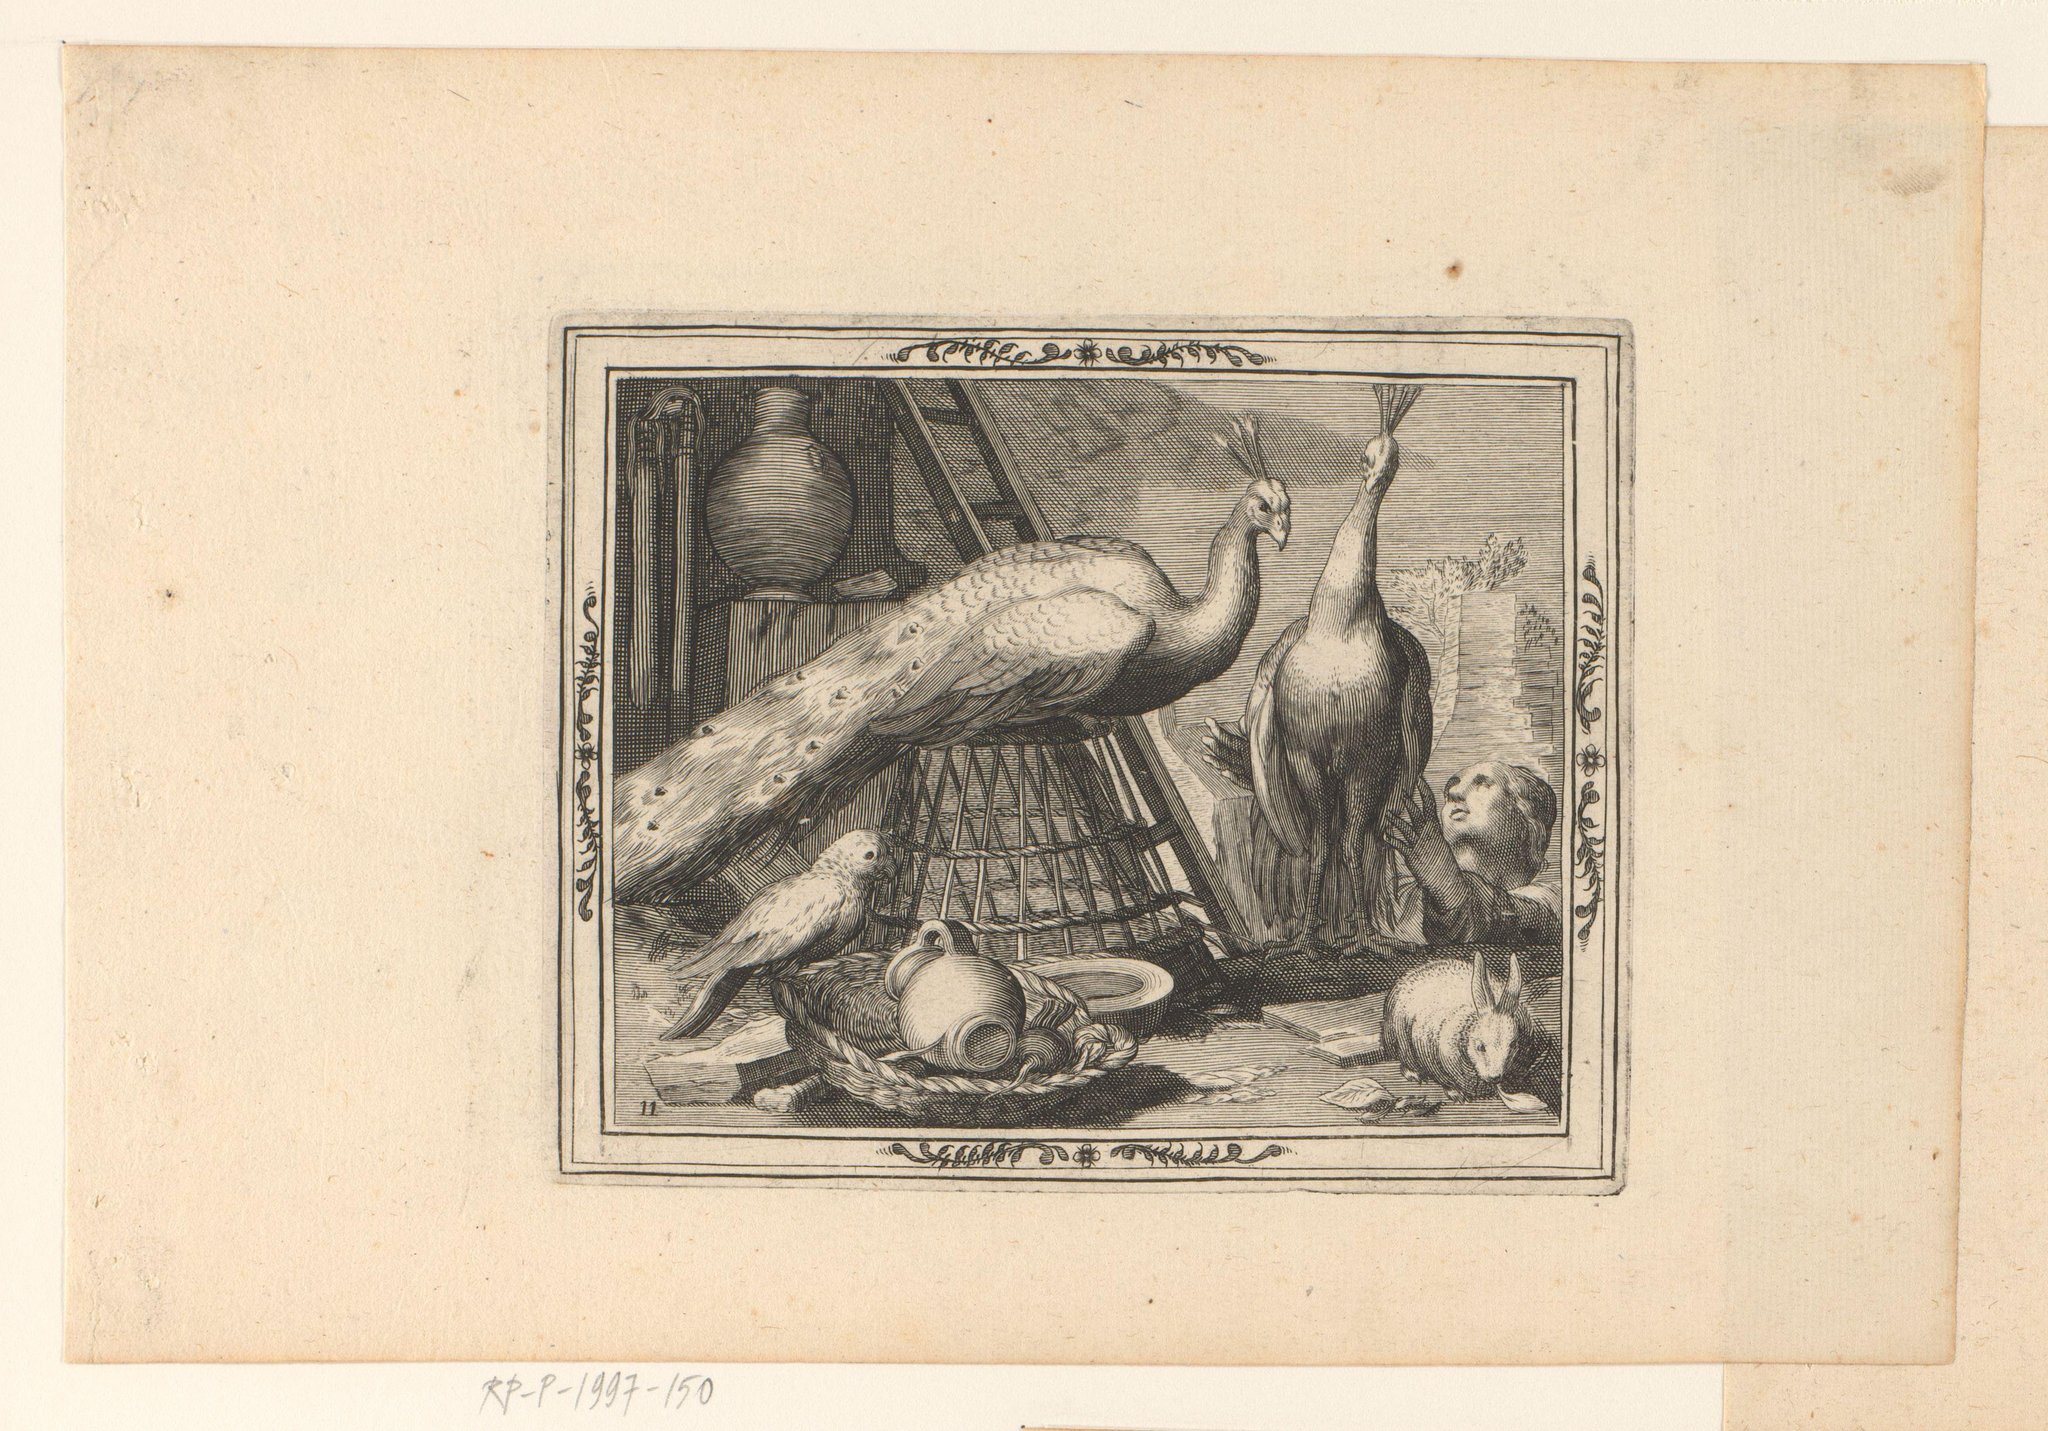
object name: print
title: Twee pauwen, een kaketoe en een konijn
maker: jean leclerc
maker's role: print maker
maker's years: 1587-1633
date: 1597-1633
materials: paper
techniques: engraving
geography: france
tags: ornamental birds: peacock, ornamental birds: cockatoo